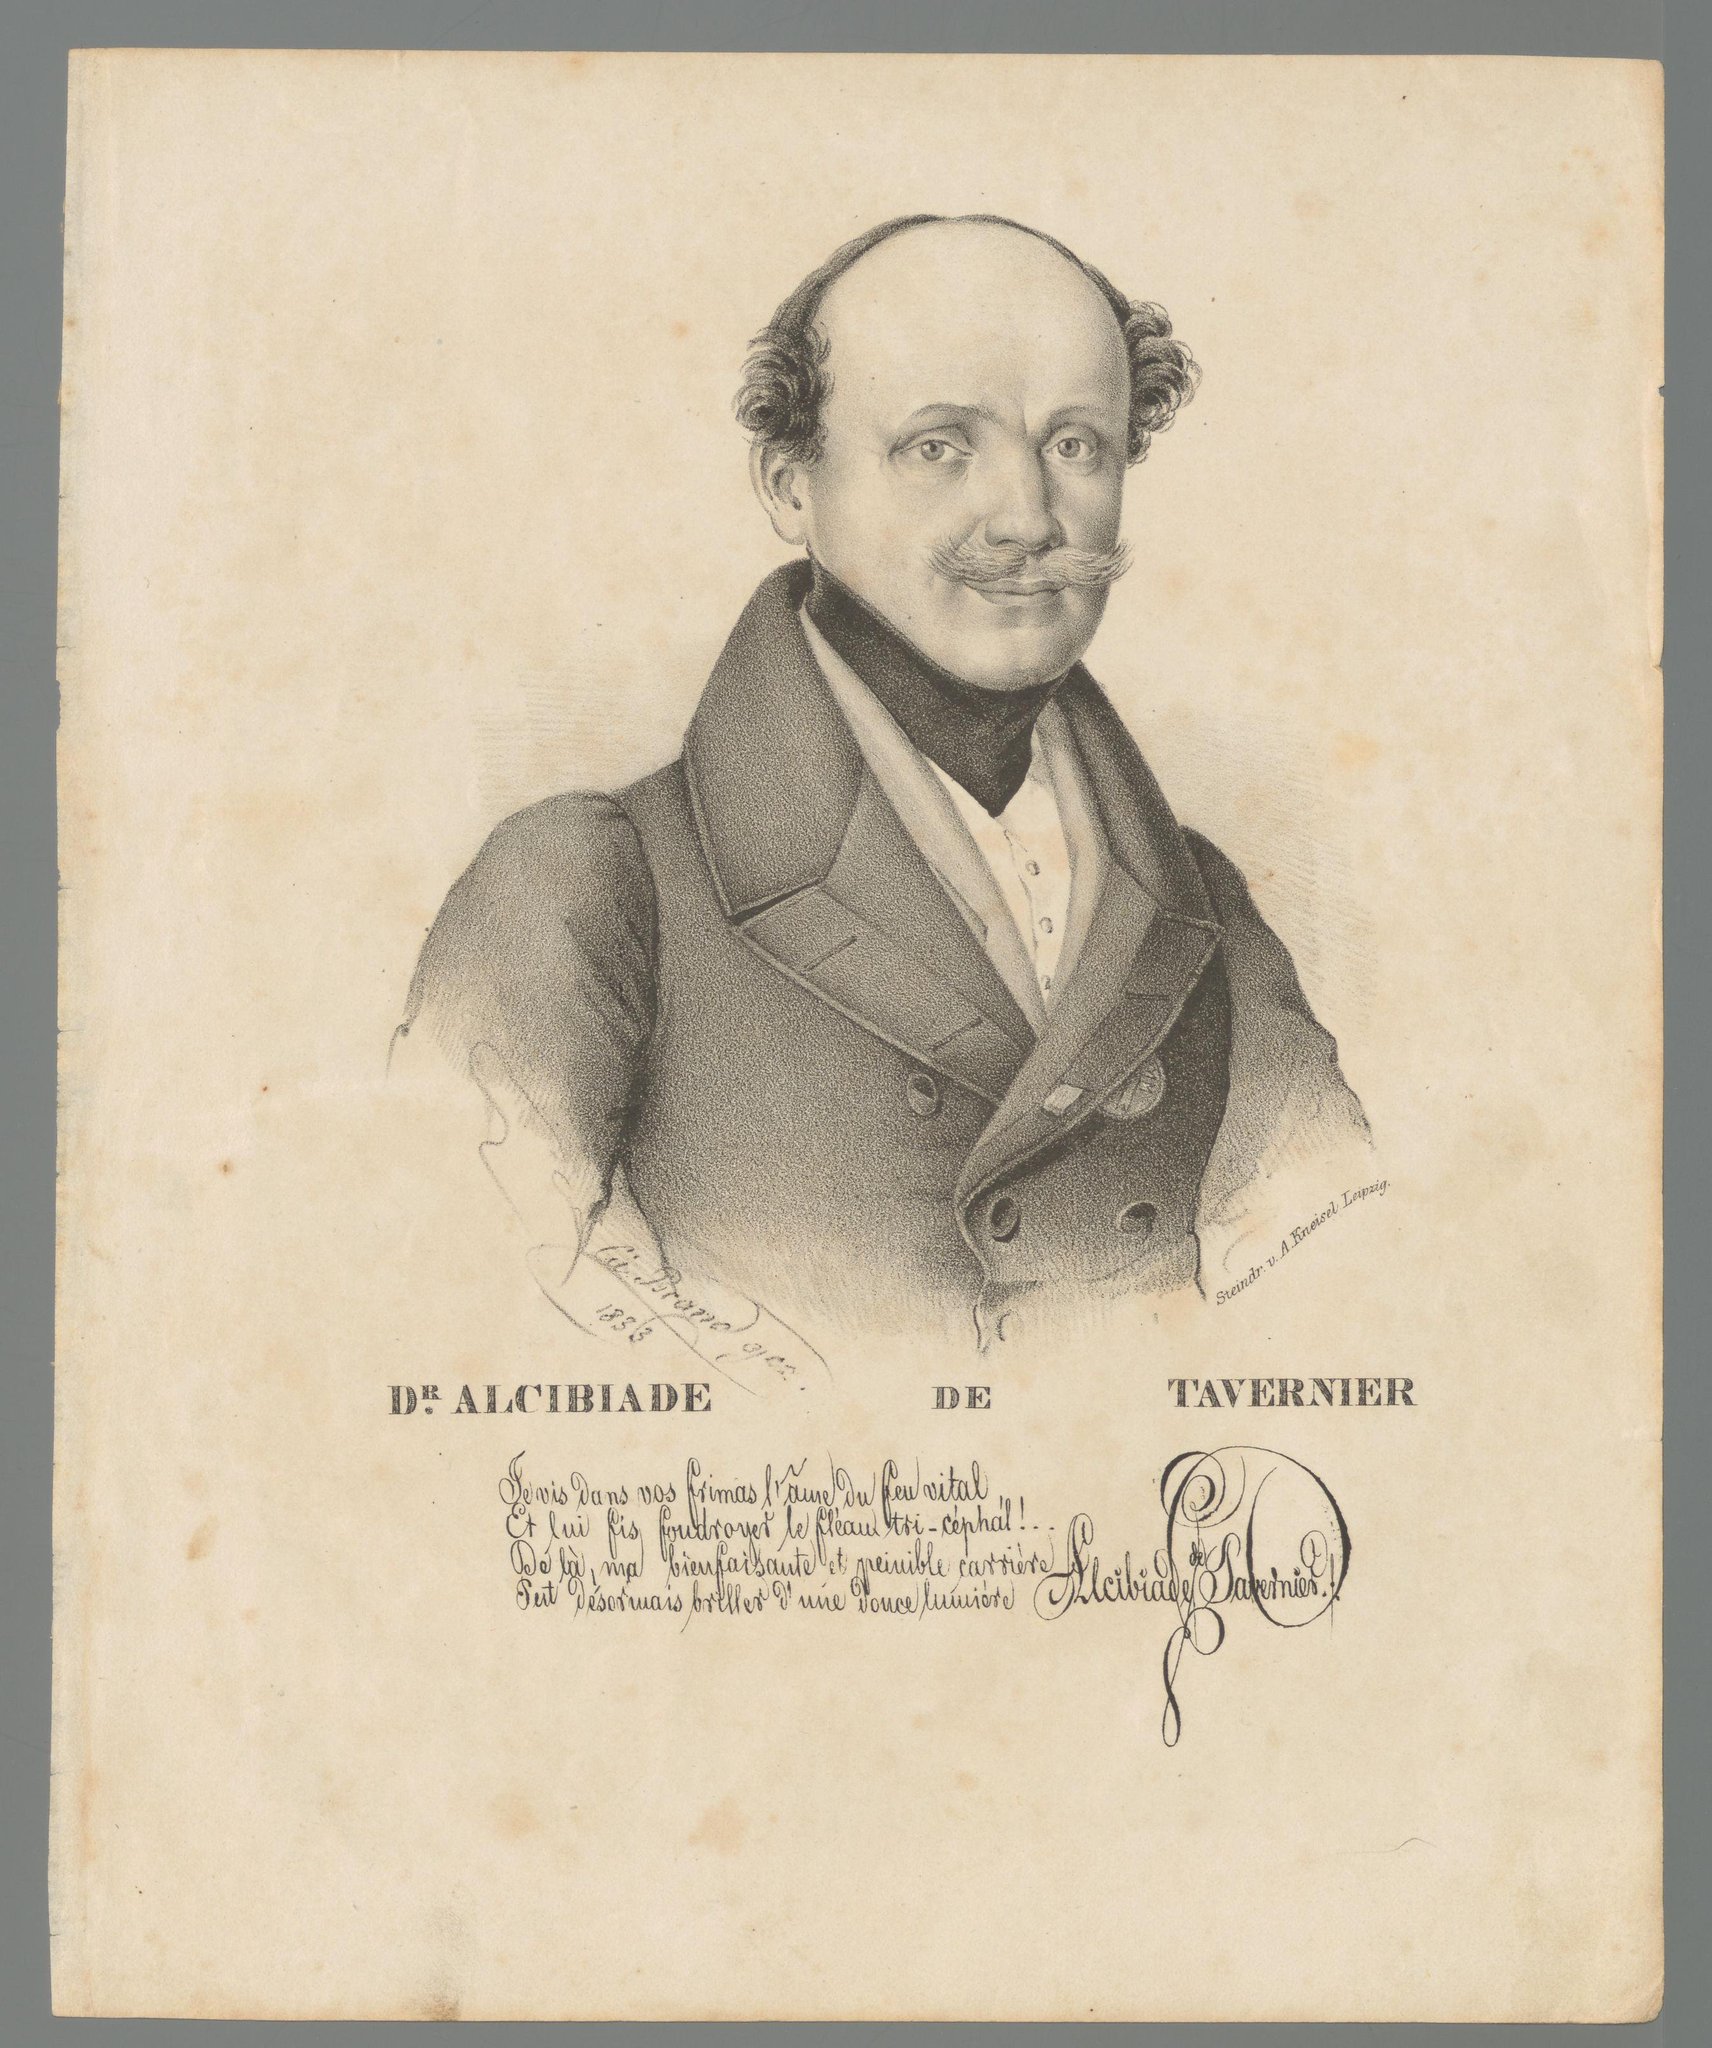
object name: print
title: Dr. Alcibiade de Tavernier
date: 1833-1839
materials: paper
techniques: lithograph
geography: leipzig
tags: moustache, adult man, historical persons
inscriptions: collector's mark: Lugt 2228, collector's mark: Lugt 2760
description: Portret Dr. Alcibiade de Tavernier: buste naar rechts. Met vier regelig gedicht in het Frans.